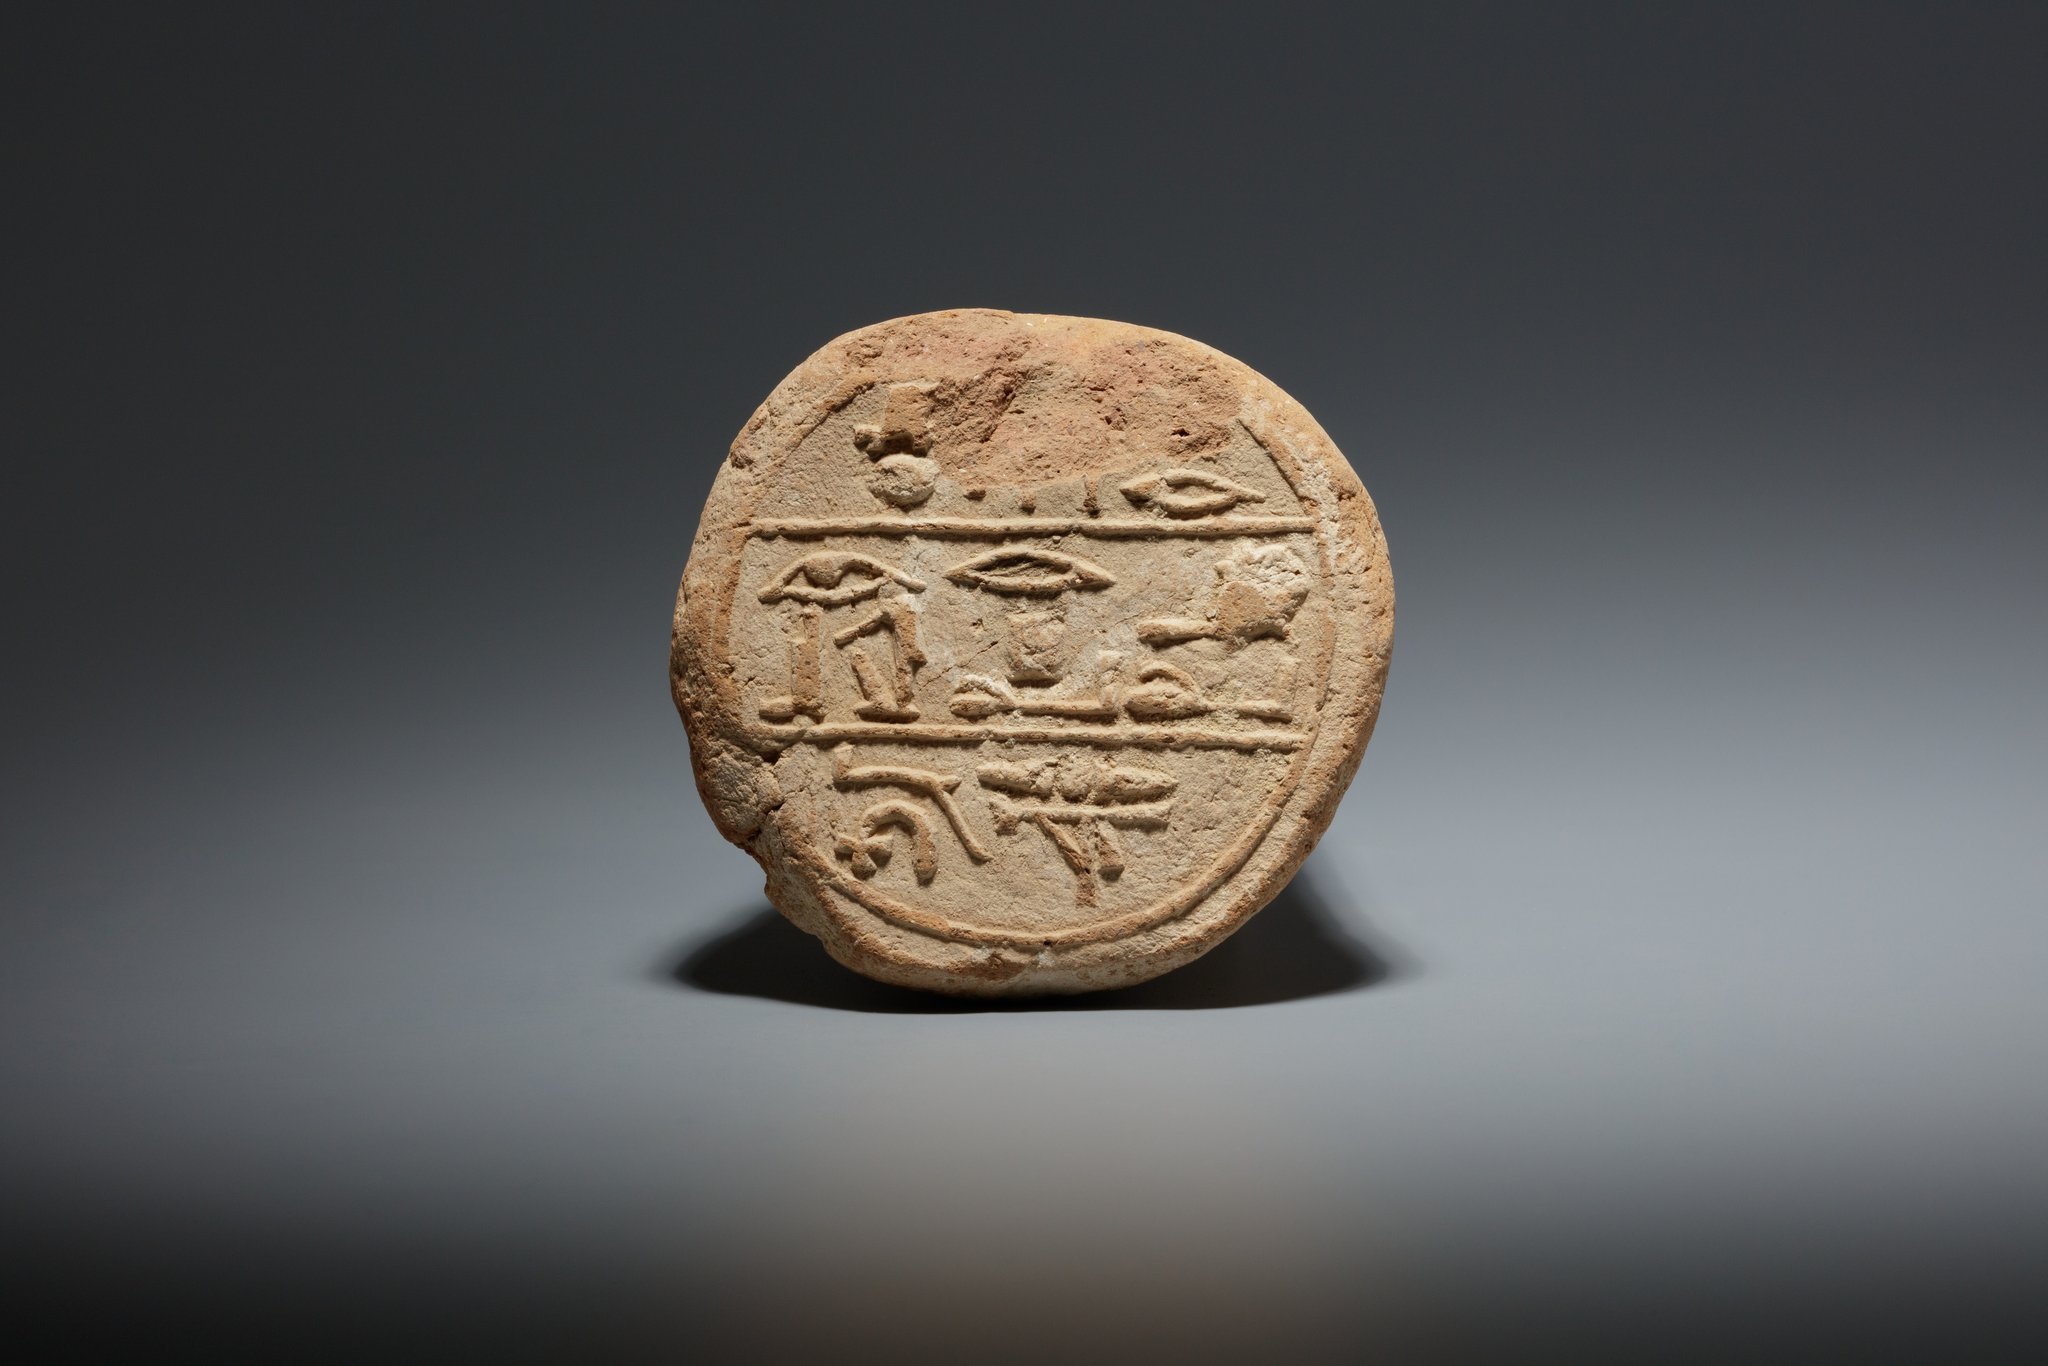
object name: cone, brick, davy 499, min, overseer, seal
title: Funerary Cone of the Overseer of the Seal Min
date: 1550-1295 BCE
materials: pottery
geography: egypt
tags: hieroglyphs